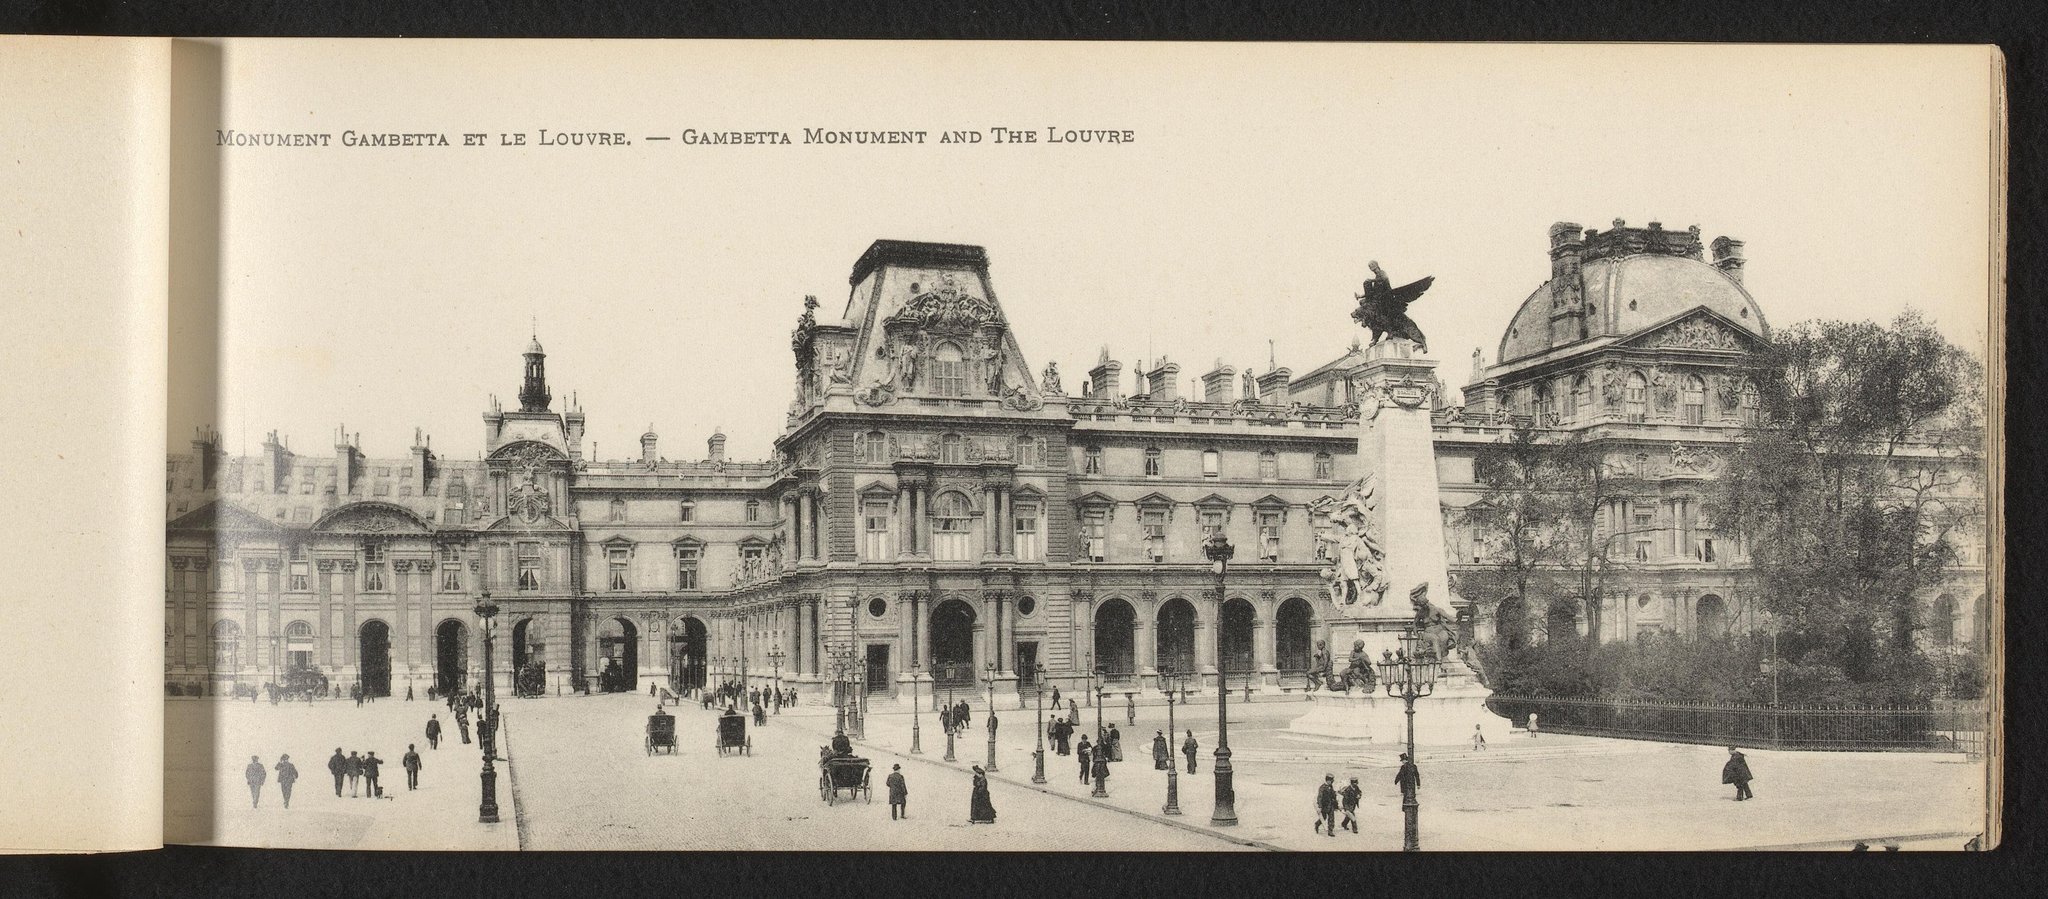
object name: photomechanical print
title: Monument Gambetta et le Louvre / Gambetta Monument and The Louvre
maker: Anonymous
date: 1920-1932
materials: cardboard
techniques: photograph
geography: paris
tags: palace, city-view, and landscape with man-made constructions (+ city(-scape) with figures, staffage), paris